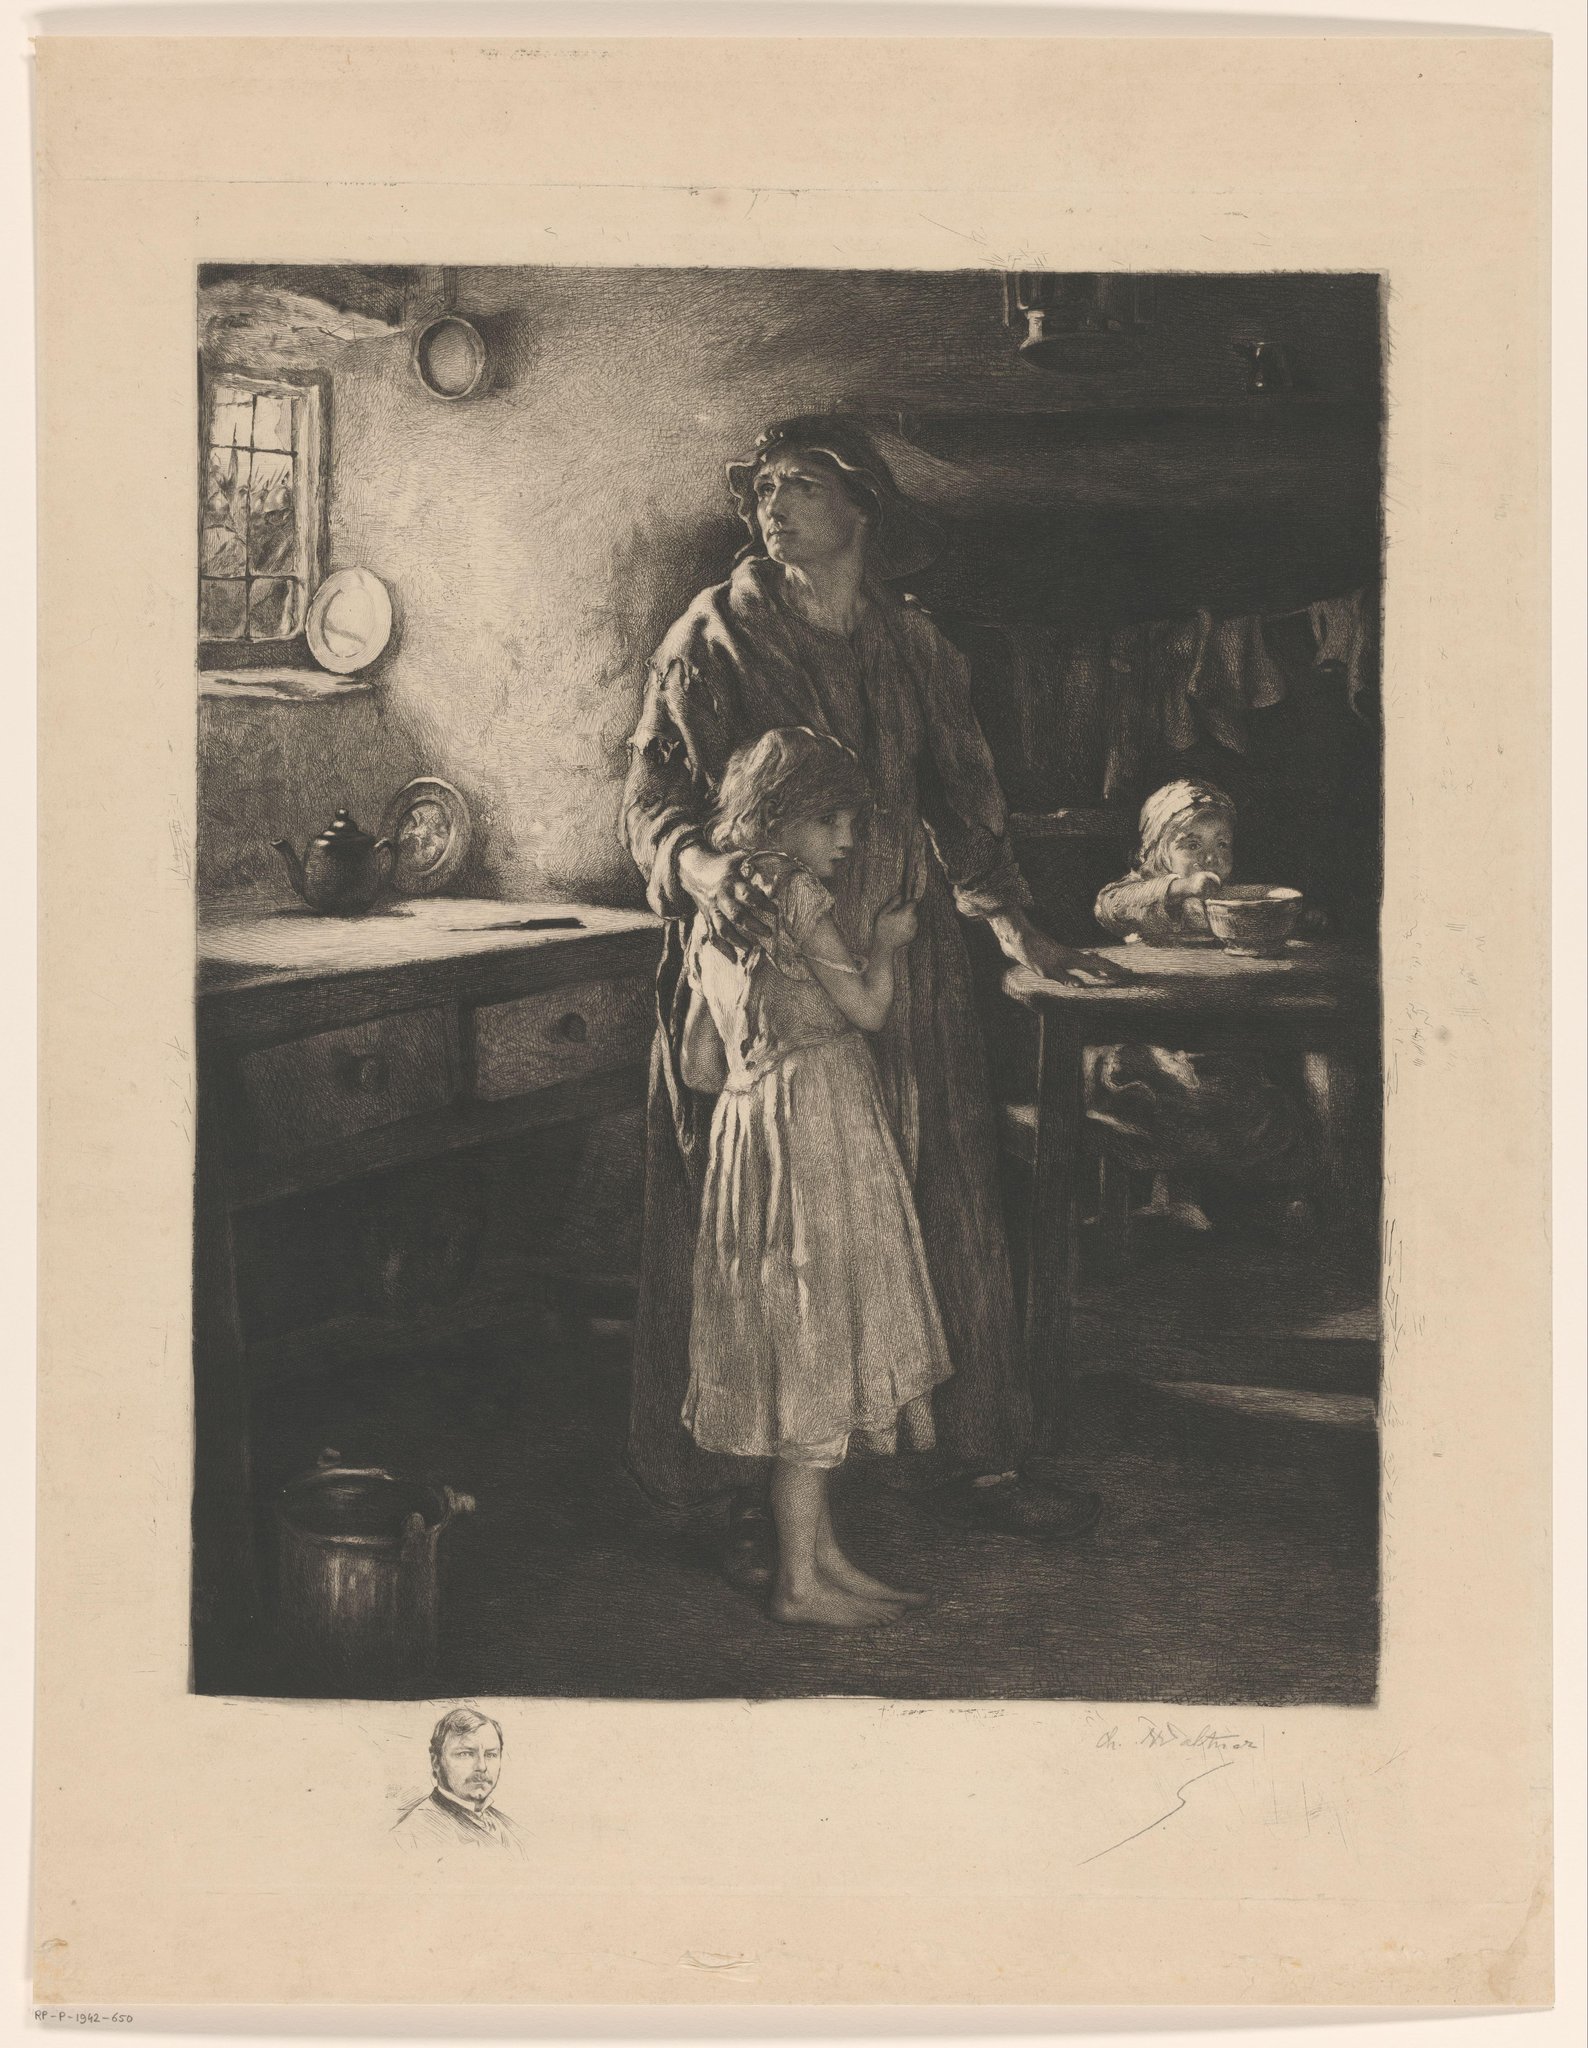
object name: print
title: Boereninterieur met vrouw en twee kinderen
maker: charles albert waltner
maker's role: print maker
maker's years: 1846-1925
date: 1856-1925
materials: paper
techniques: drypoint, etching, intaglio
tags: farmers, interior of the house, mother and baby or young child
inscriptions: collector's mark: Lugt 2228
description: Boereninterieur met vrouw en twee kinderen, met in de marge een portret van een man.